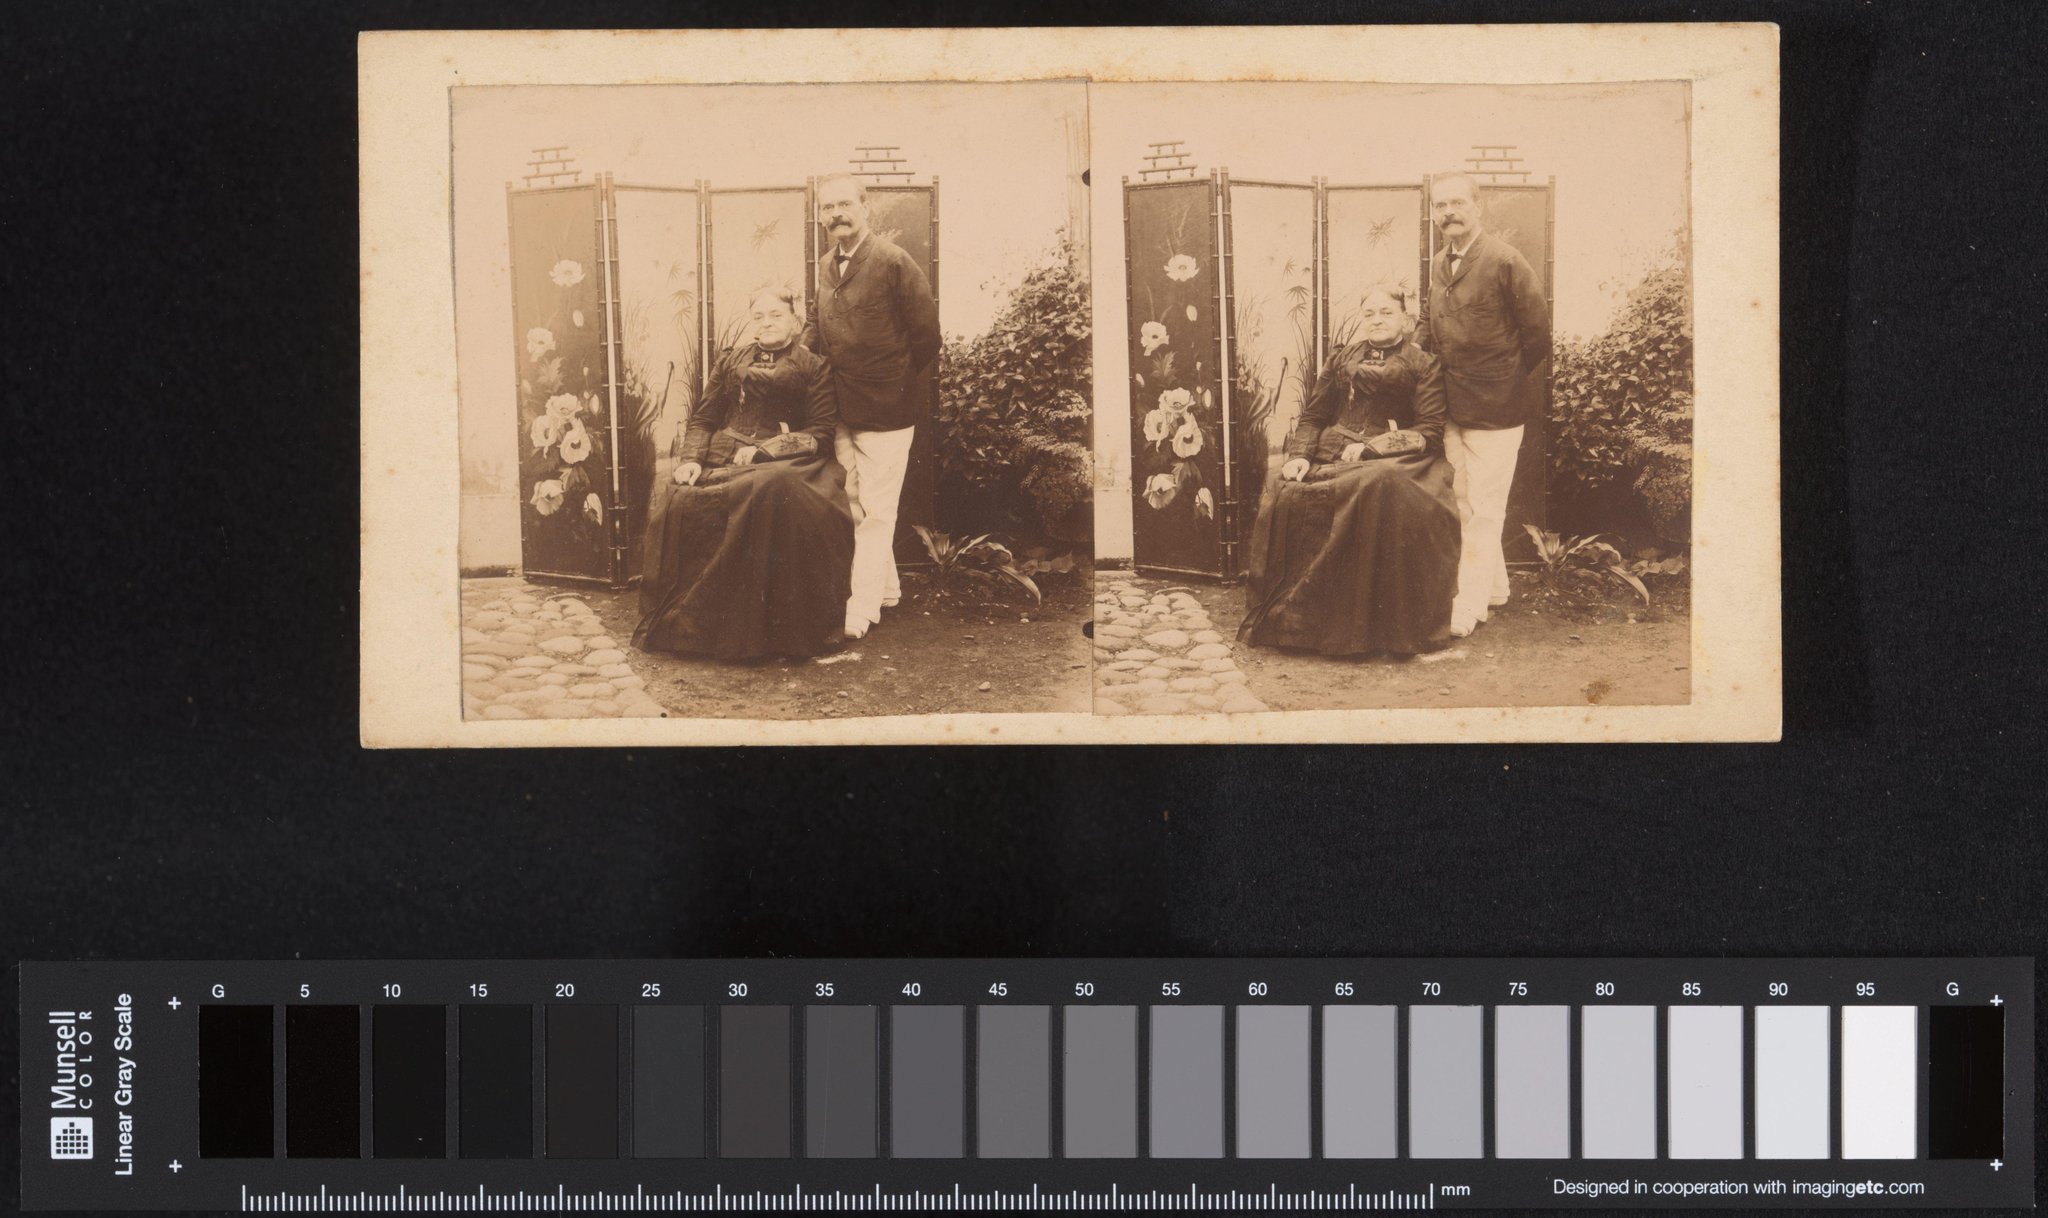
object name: stereograph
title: Echtpaar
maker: robert julius boers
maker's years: 1867-1932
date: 1900-1922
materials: cardboard, photographic support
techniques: gelatin silver print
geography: bangka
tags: robert julius boers, dutch east indies, the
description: Portret van een Europees echtpaar voor een kamerscherm, waarschijnlijk te Banka. Onderdeel van een groep stereofoto's van Robert Julius Boers, chef van het staatsbedrijf de Banka-tinwinning op Banka, uit de periode ca. 1900-1922.